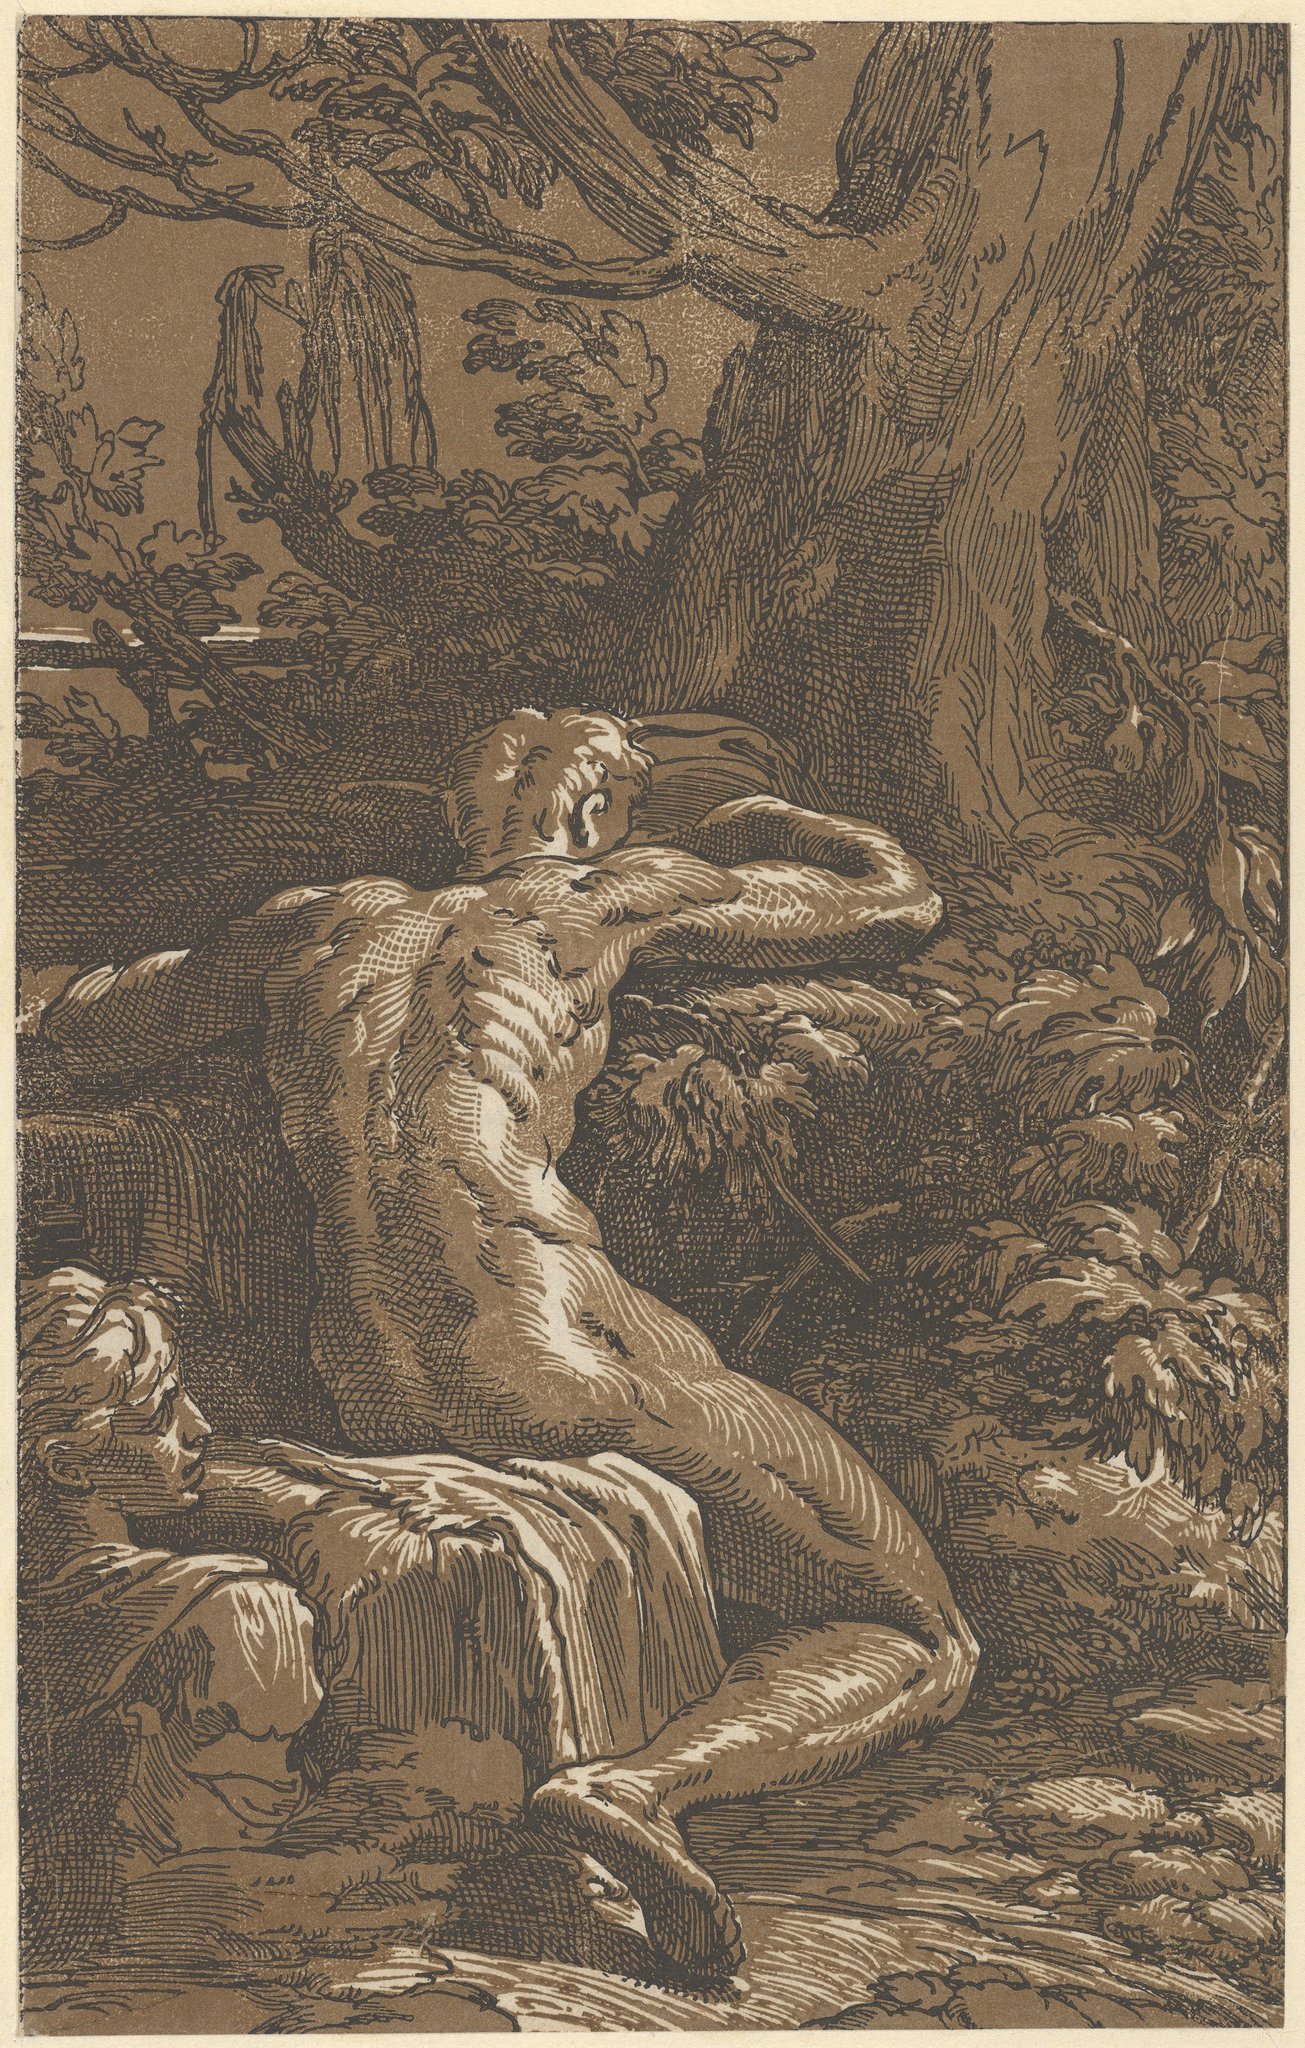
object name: print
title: Man seated viewed from behind (Narcissus)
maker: antonio da trento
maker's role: artist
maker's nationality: italian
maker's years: 1510-1550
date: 1527-1530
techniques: woodcut, printing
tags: male nudes,narcissus